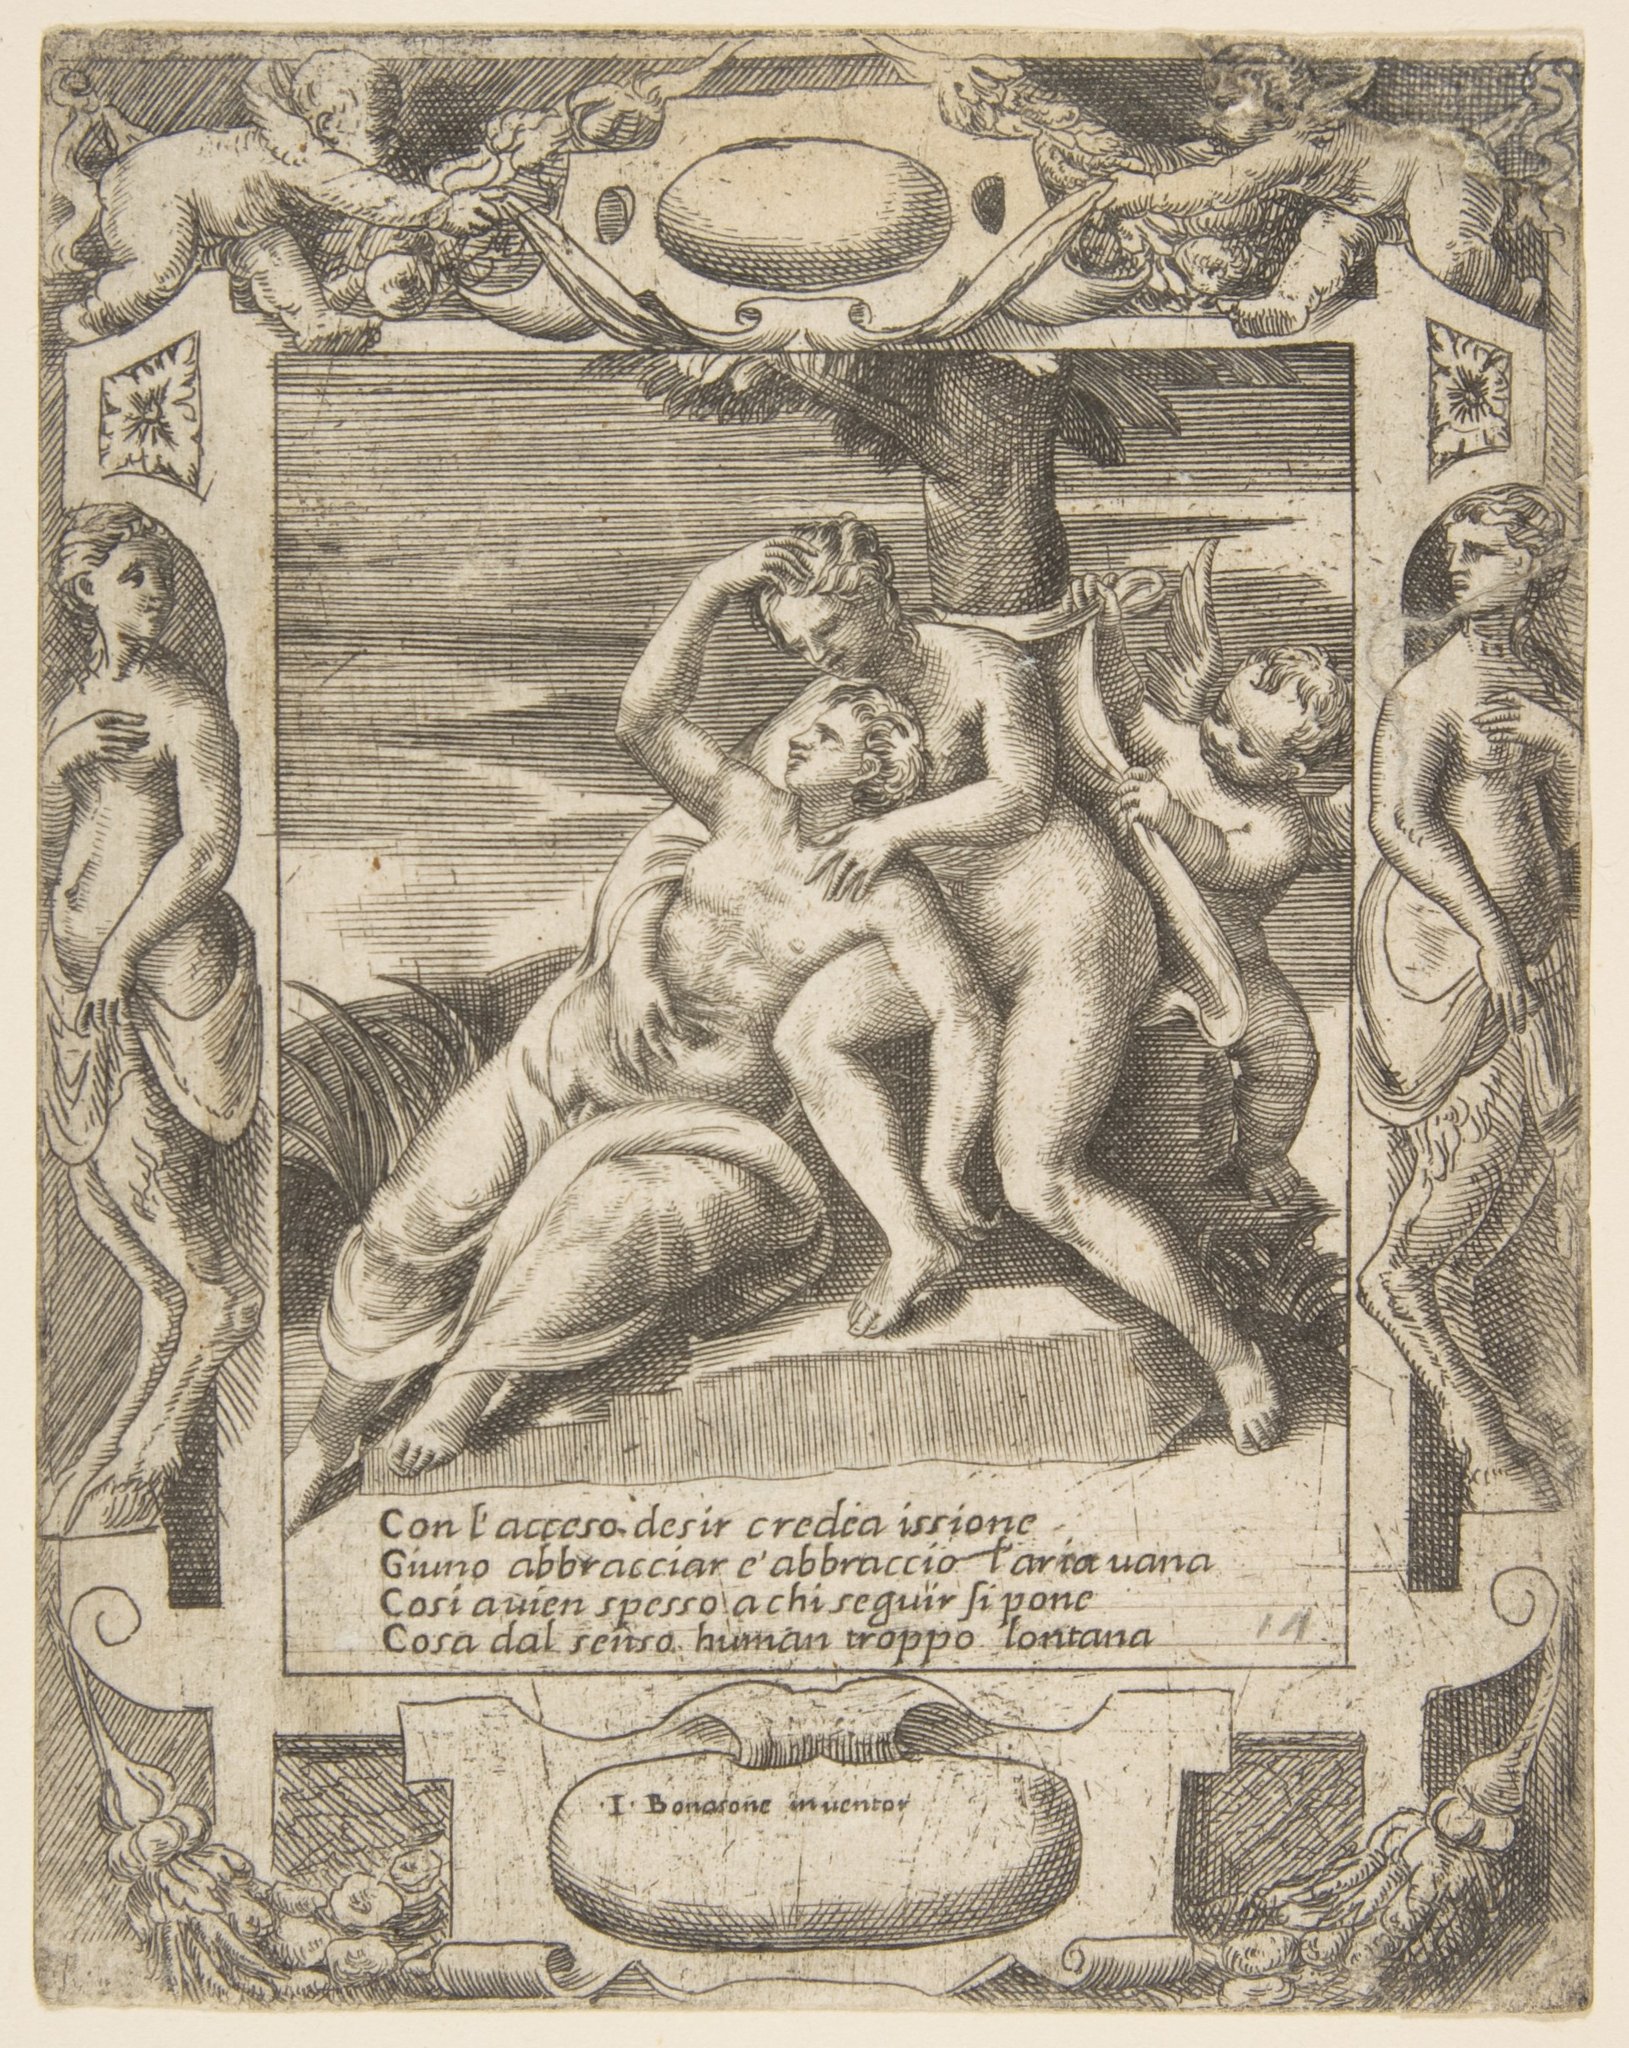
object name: print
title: Ixion embracing a cloud, thinking it is Juno, Cupid at the right, set within an elaborate frame, from "Loves, Rages and Jealousies of Juno"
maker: giulio bonasone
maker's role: artist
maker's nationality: italian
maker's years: 1510-1576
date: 1531-1576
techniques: engraving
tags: cupid,juno,angels